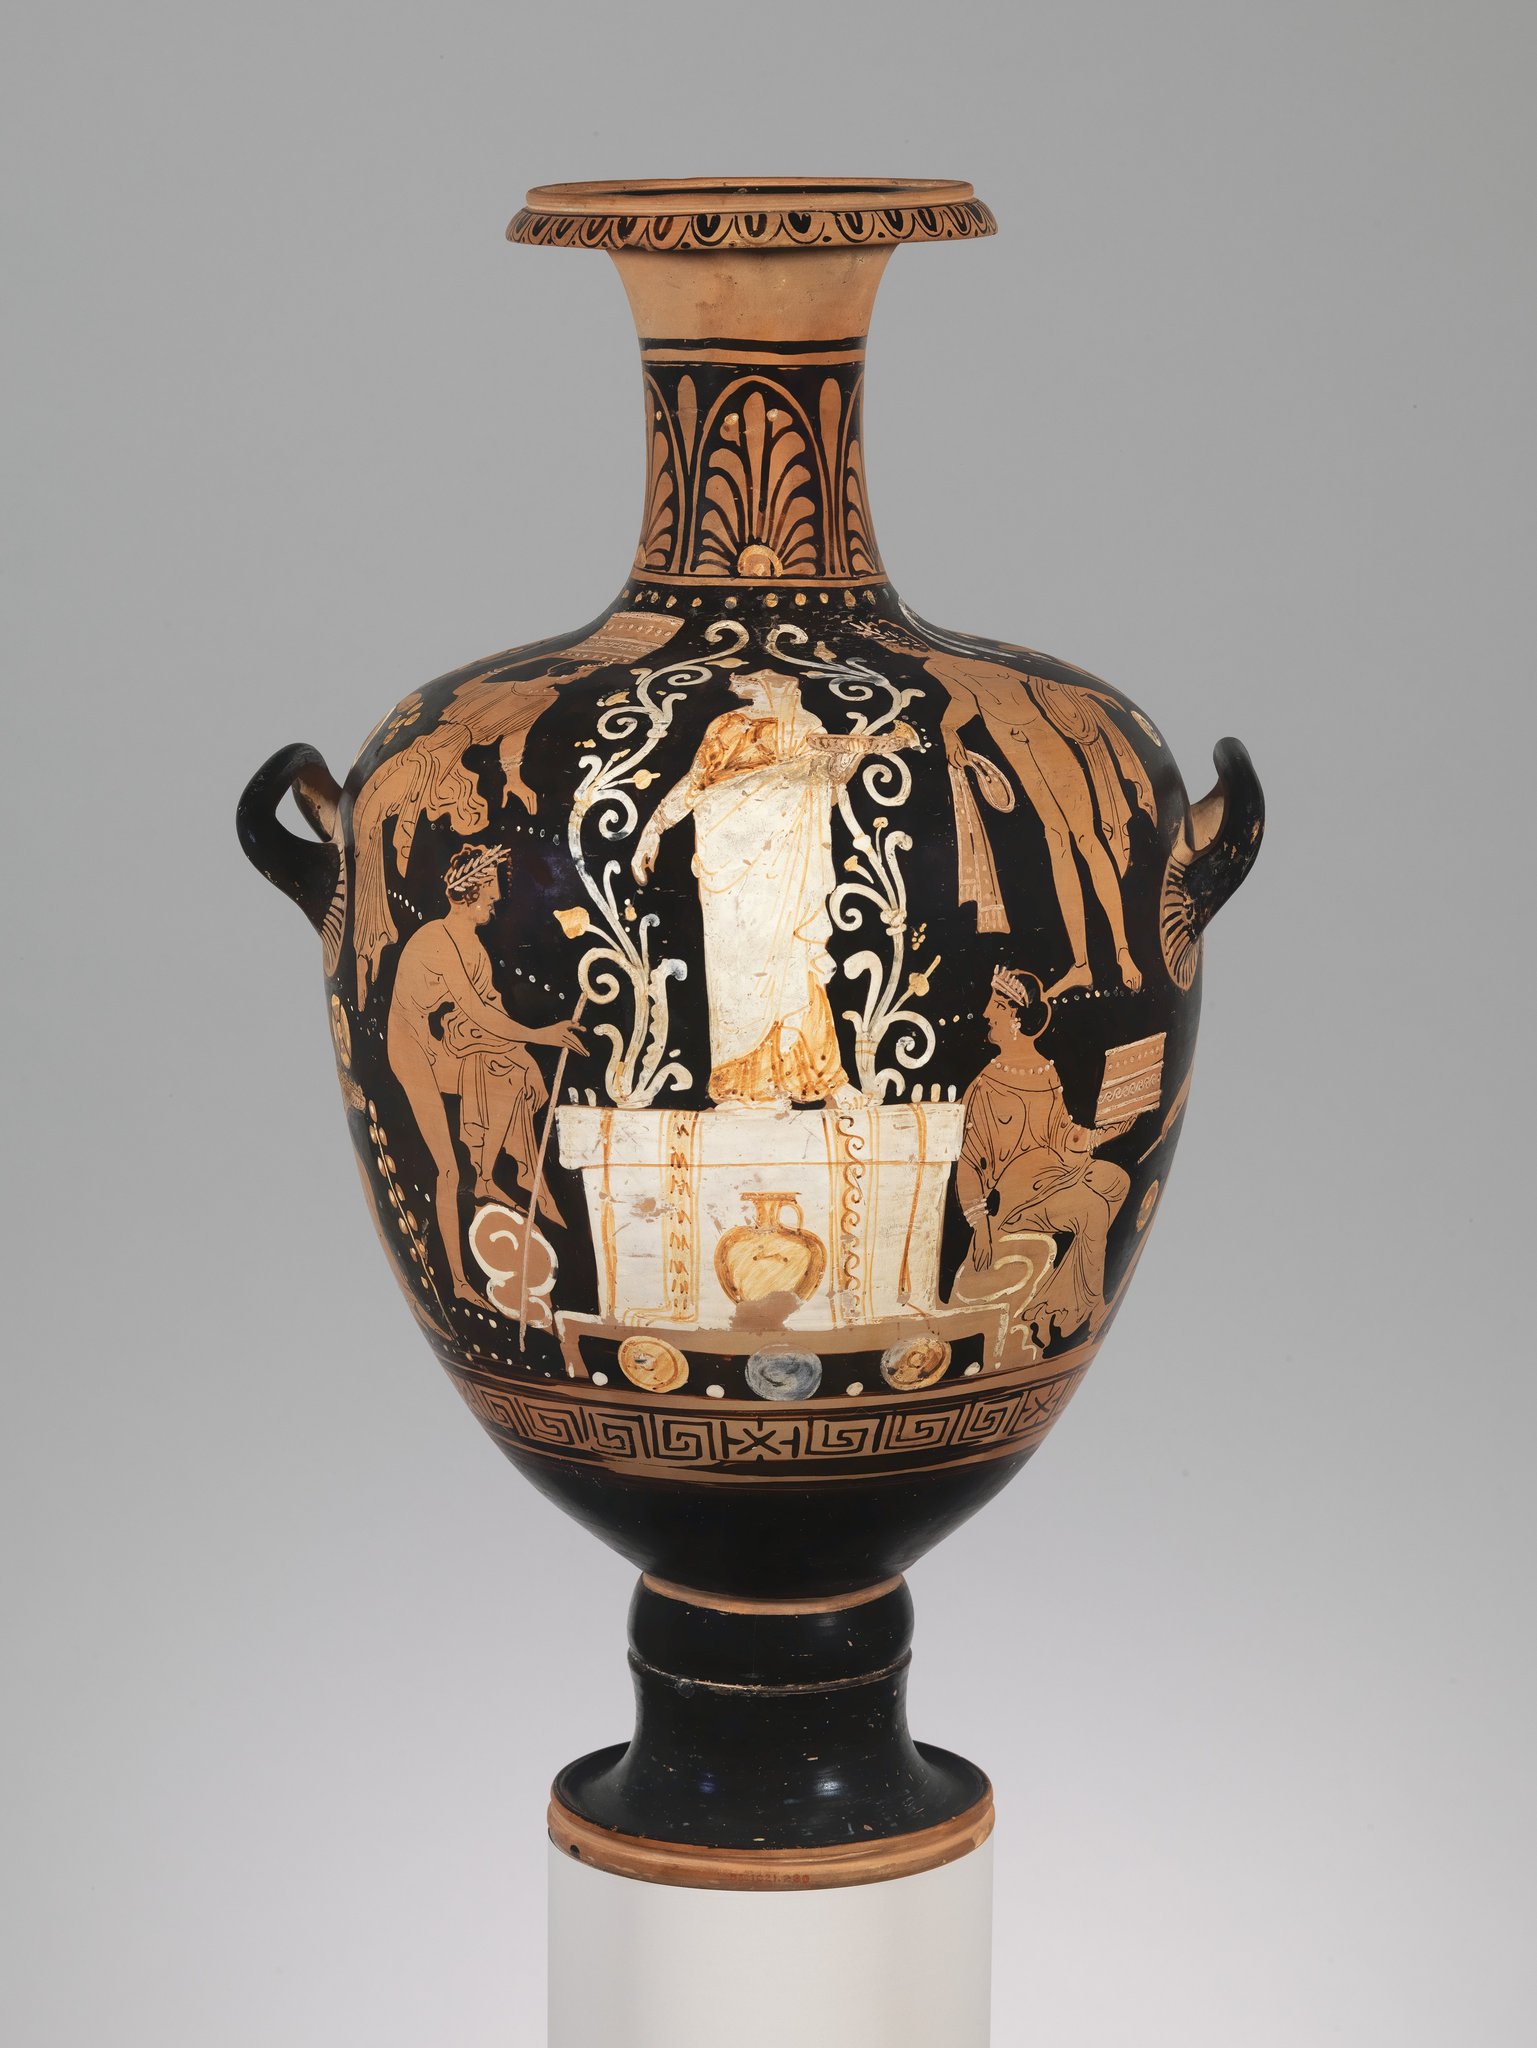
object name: hydria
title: Terracotta hydria (water jar)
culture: greek or south italian or campanian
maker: olcott painter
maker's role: artist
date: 360-330 BCE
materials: terracotta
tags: tombs,male nudes,women